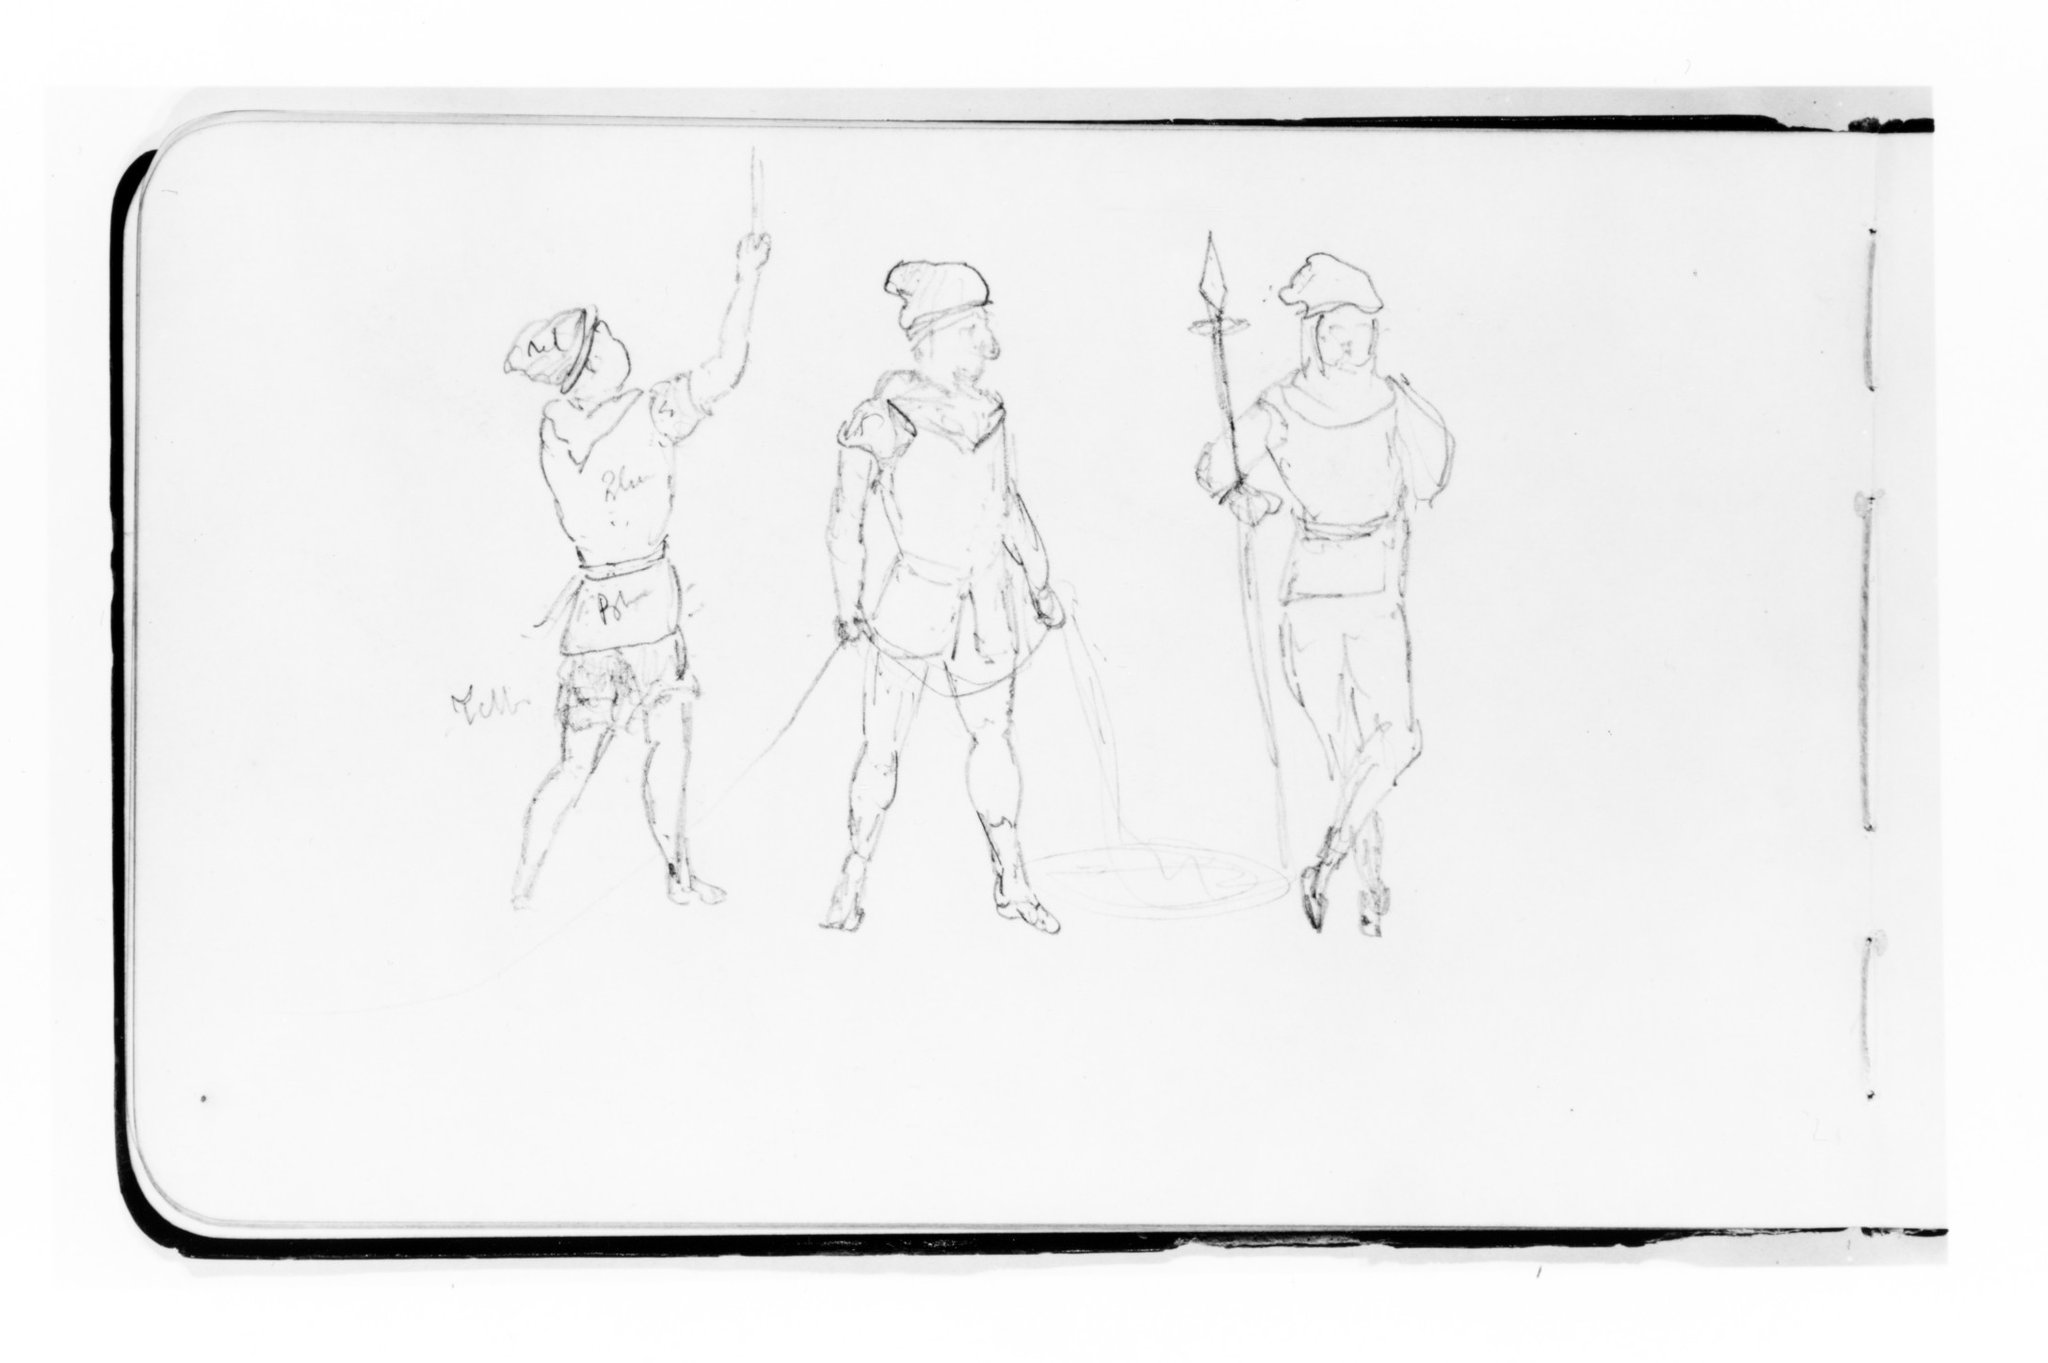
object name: drawing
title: Three Figures (from Sketchbook)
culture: american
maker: albert bierstadt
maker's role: artist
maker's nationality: american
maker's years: 1830-1902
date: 1891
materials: gilt, graphite, leather, paper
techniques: bookbinding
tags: soldiers,weapons,men